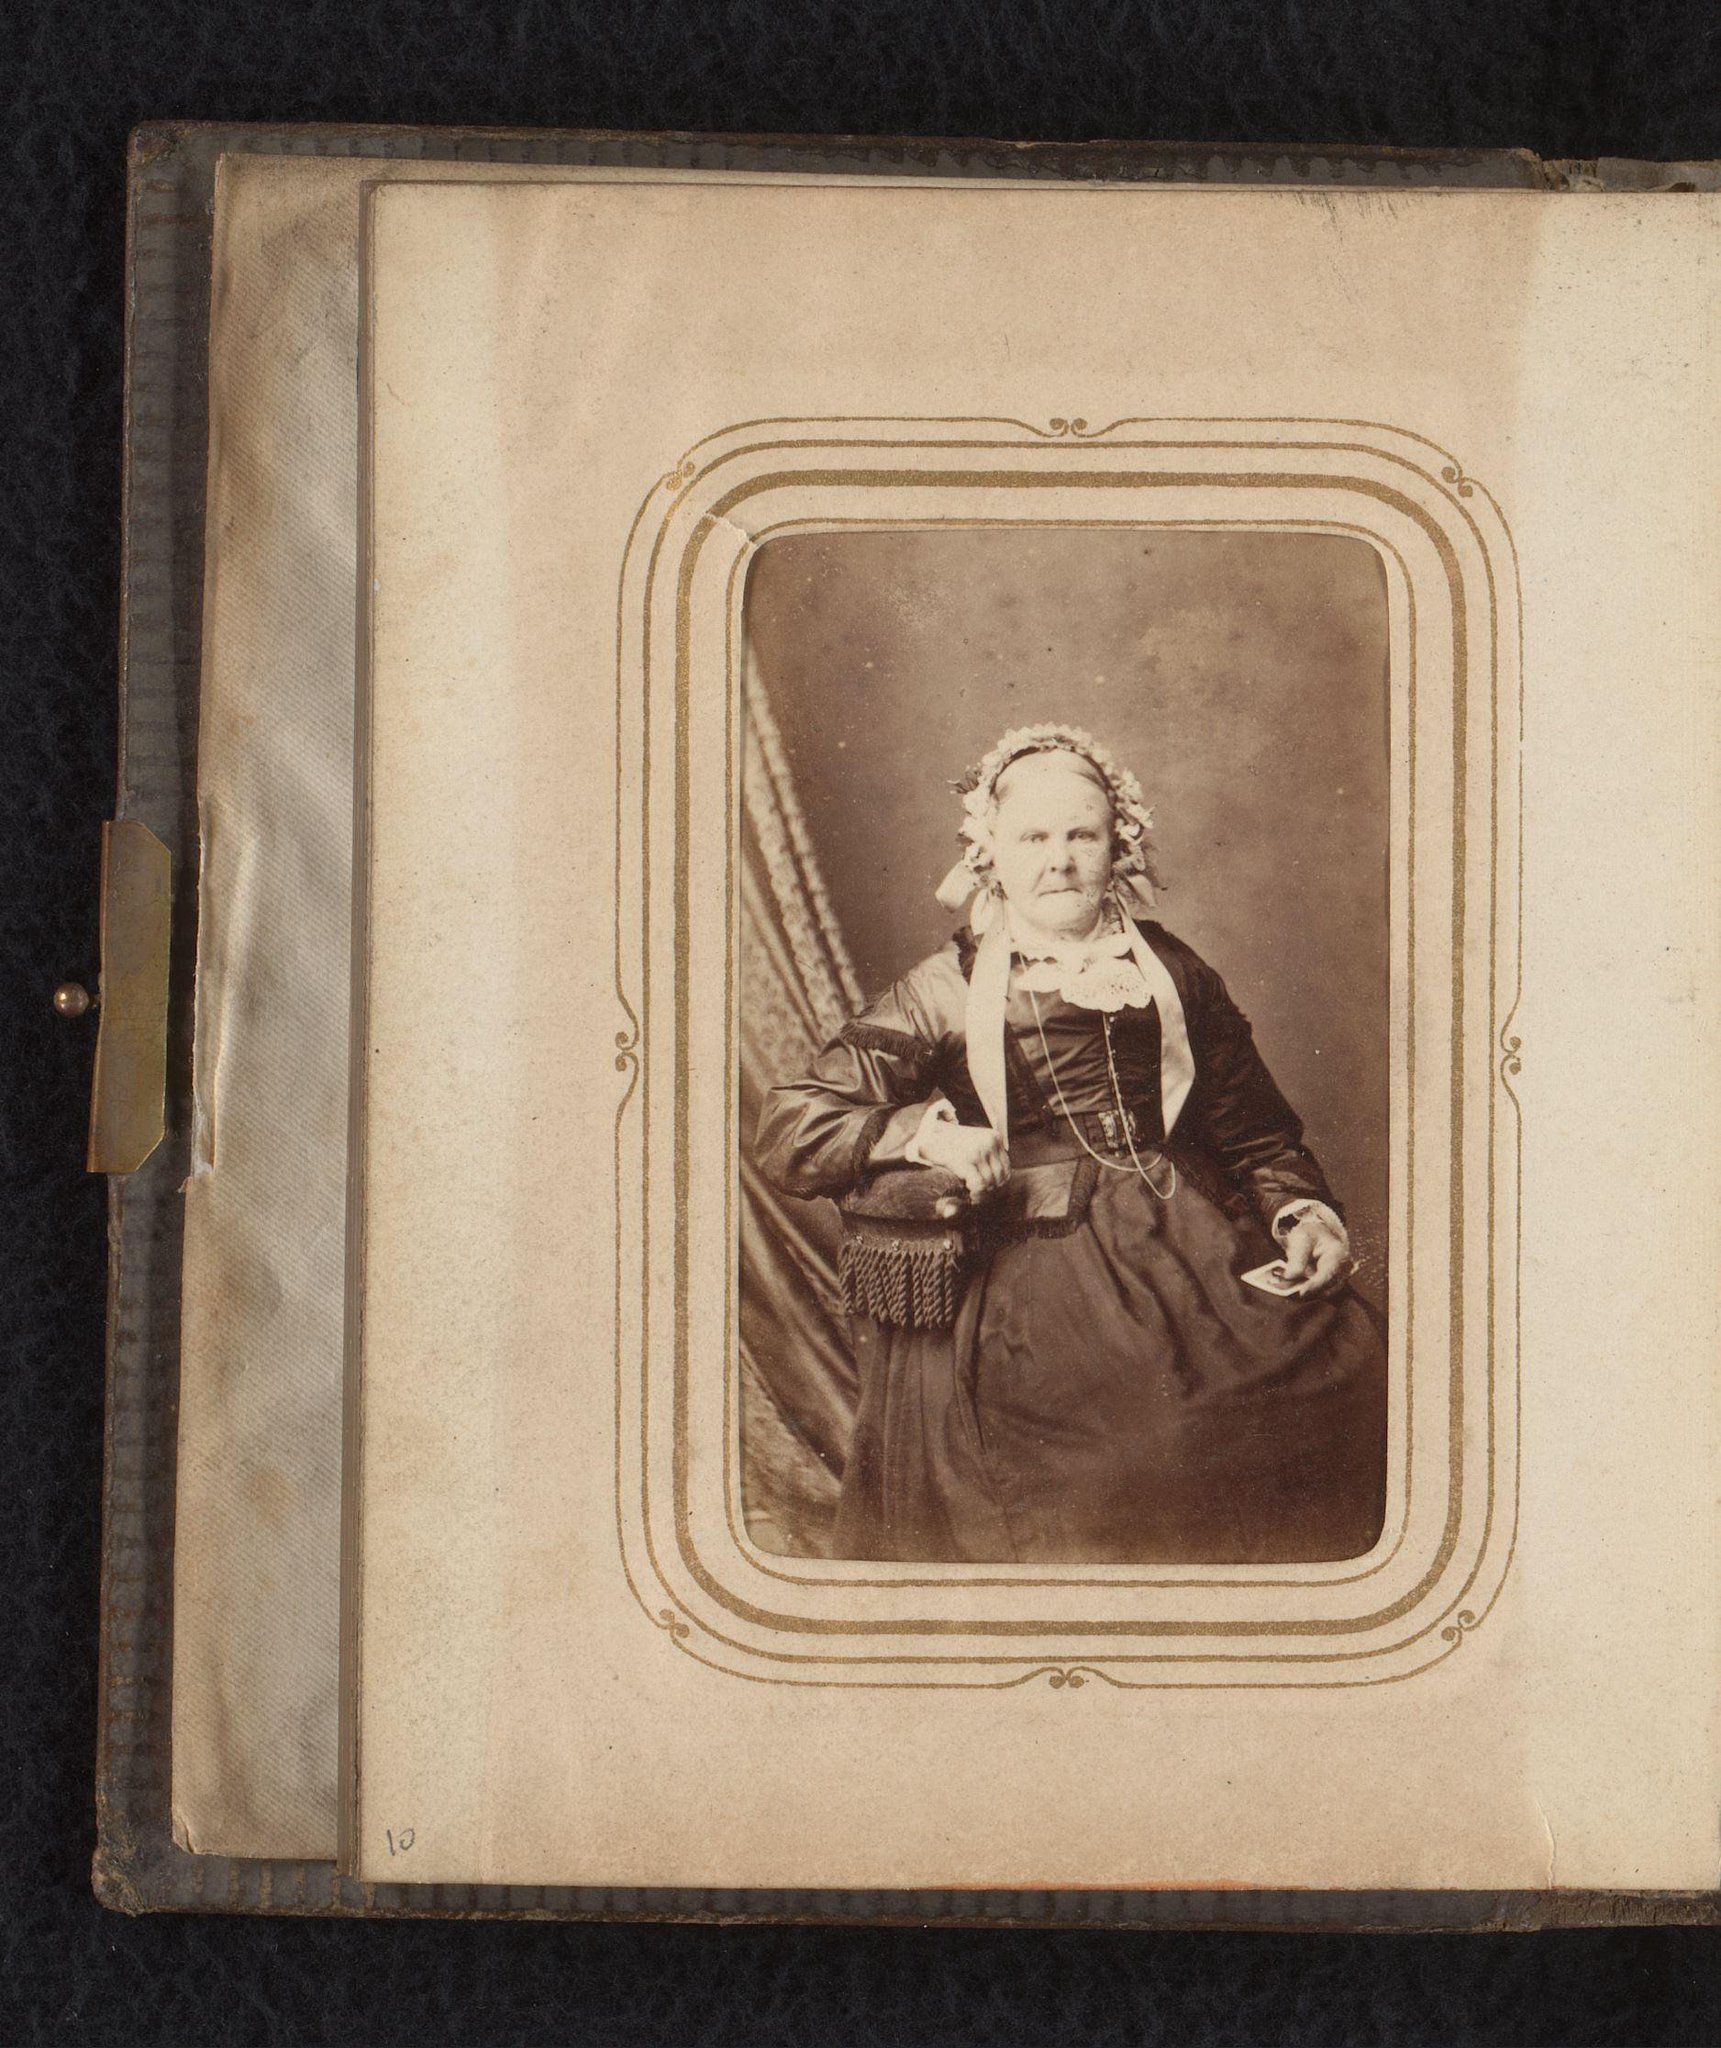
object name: photograph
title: Portret van een zittende oude vrouw met muts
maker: frederick argall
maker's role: fotograaf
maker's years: 1847-1900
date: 1860-1900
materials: cardboard, photographic support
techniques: albumen print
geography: truro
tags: historical persons - bb - woman, head-gear: cap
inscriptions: inscription: ‘Fredk. Argall/ Photographer/ High Cross/ Truro’